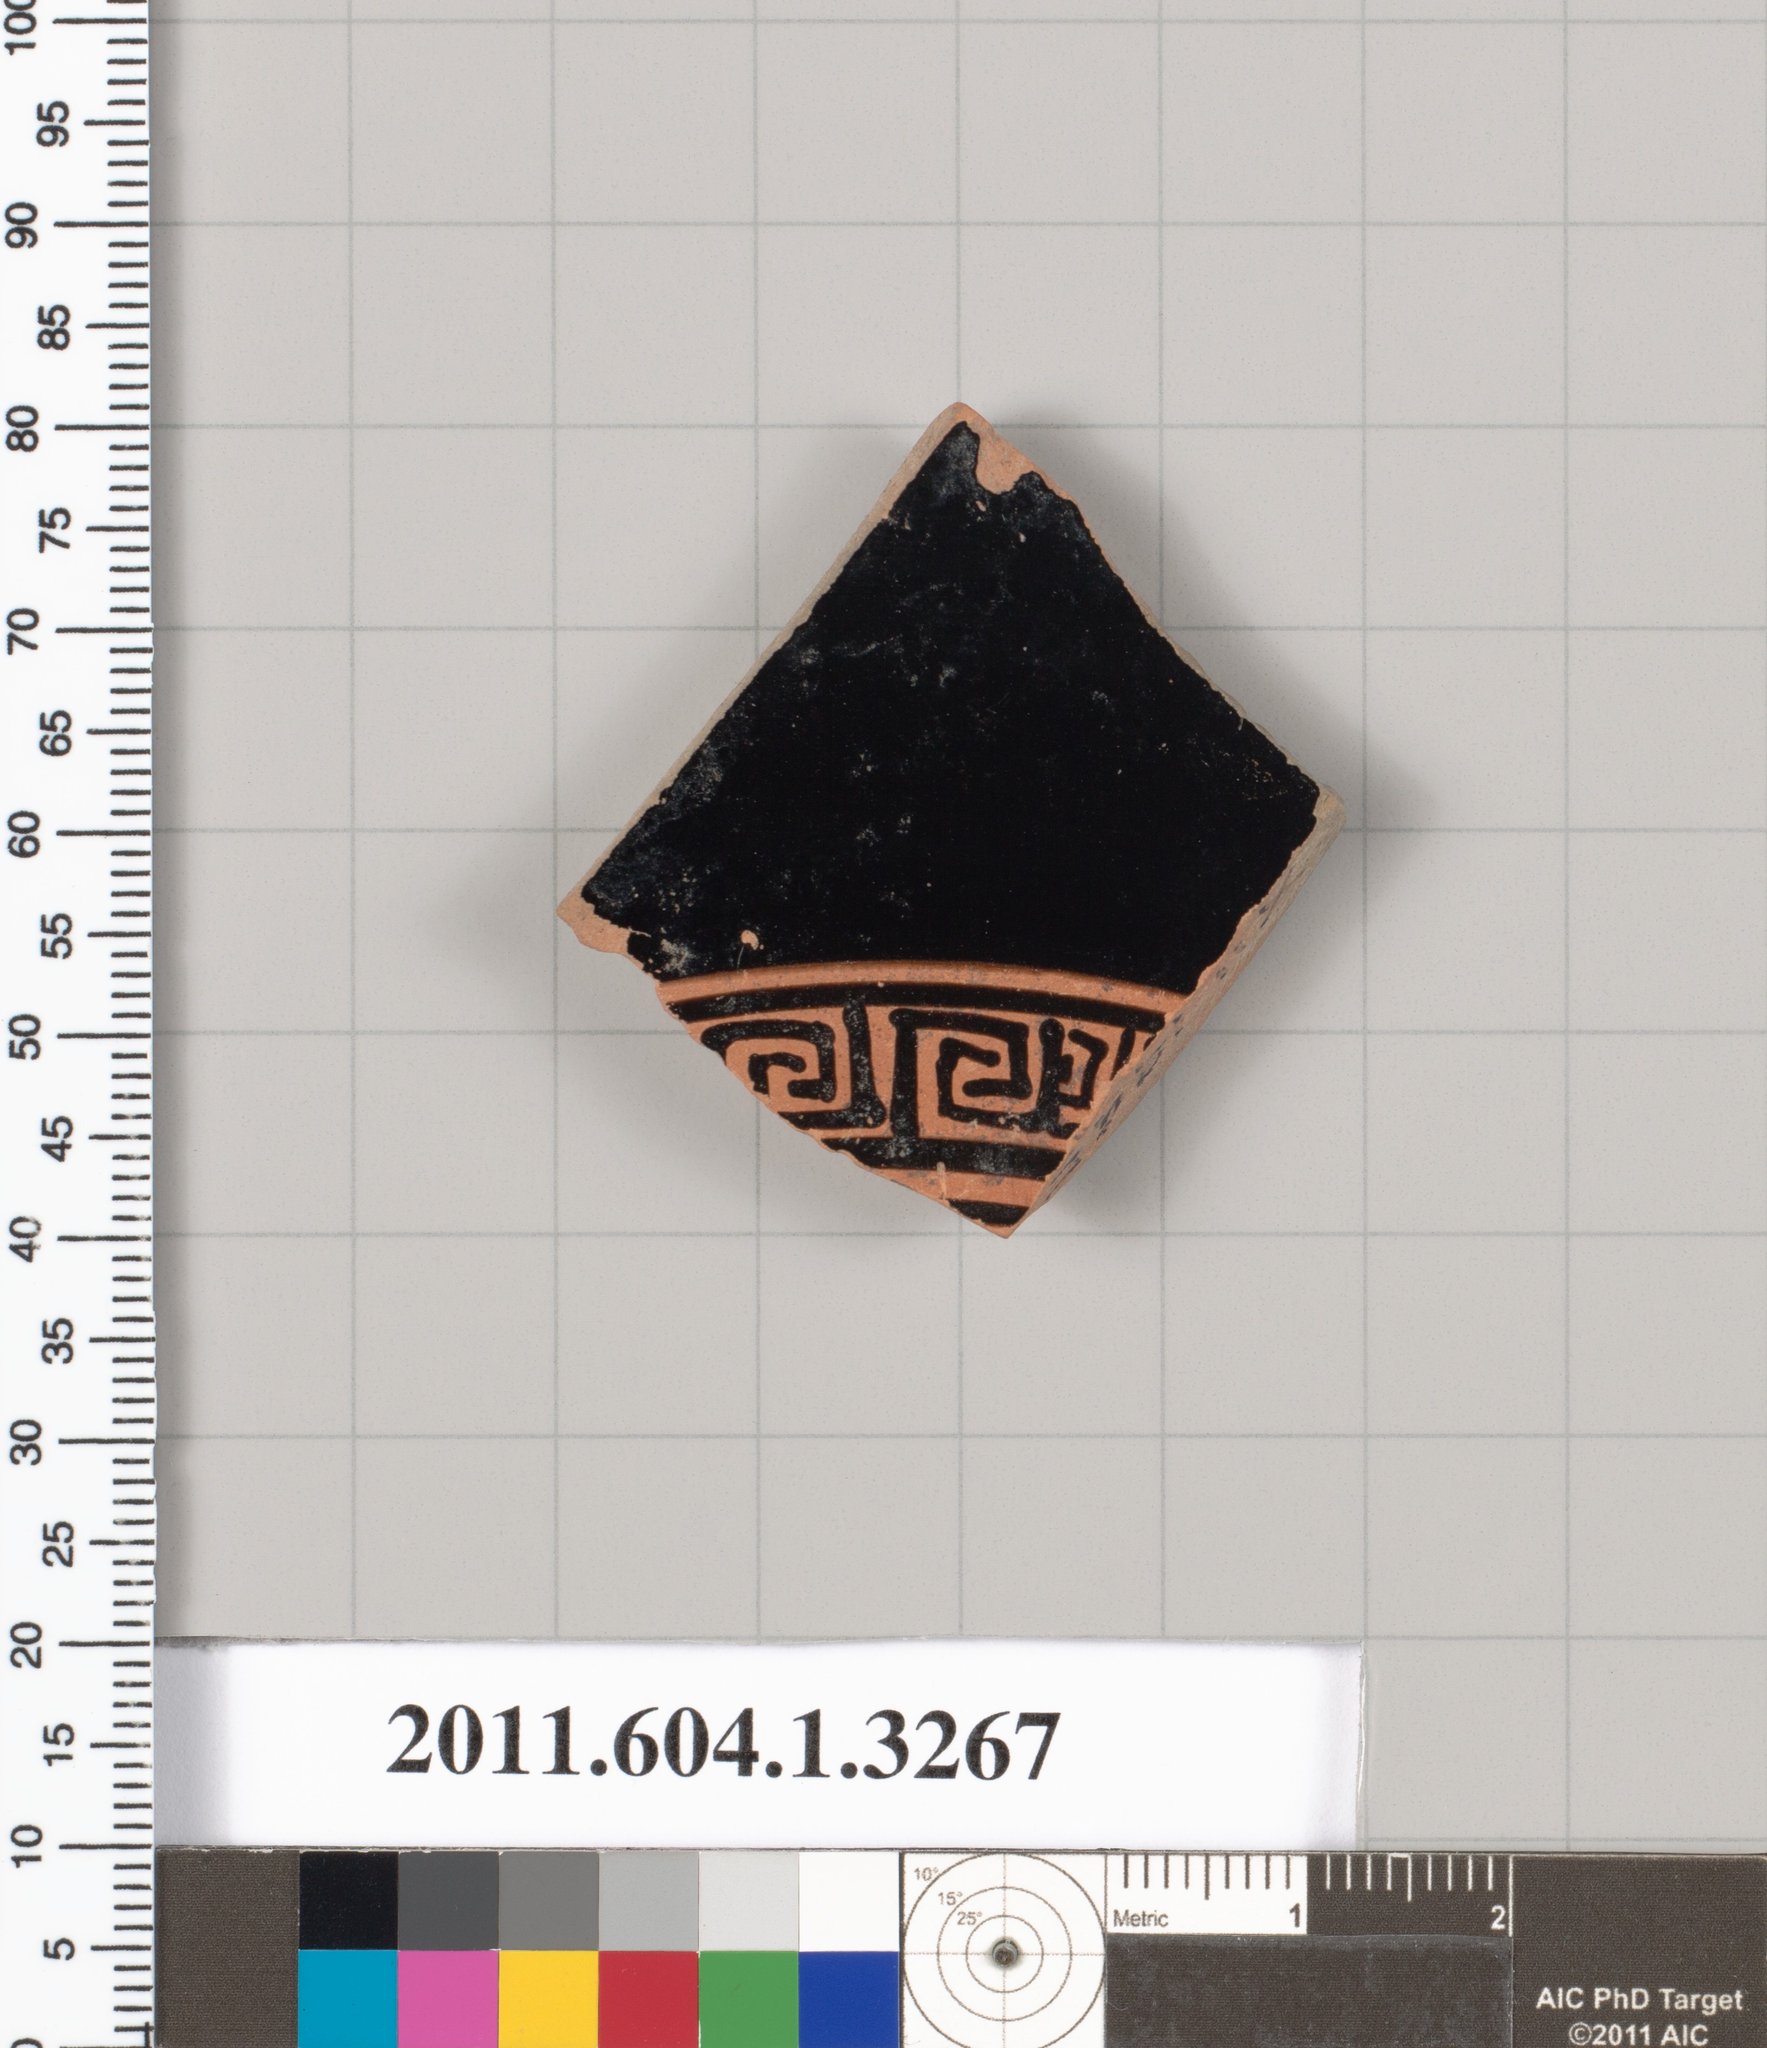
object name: kylix fragment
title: Terracotta fragment of a kylix (drinking cup)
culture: greek, attic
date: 500-490 BCE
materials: terracotta